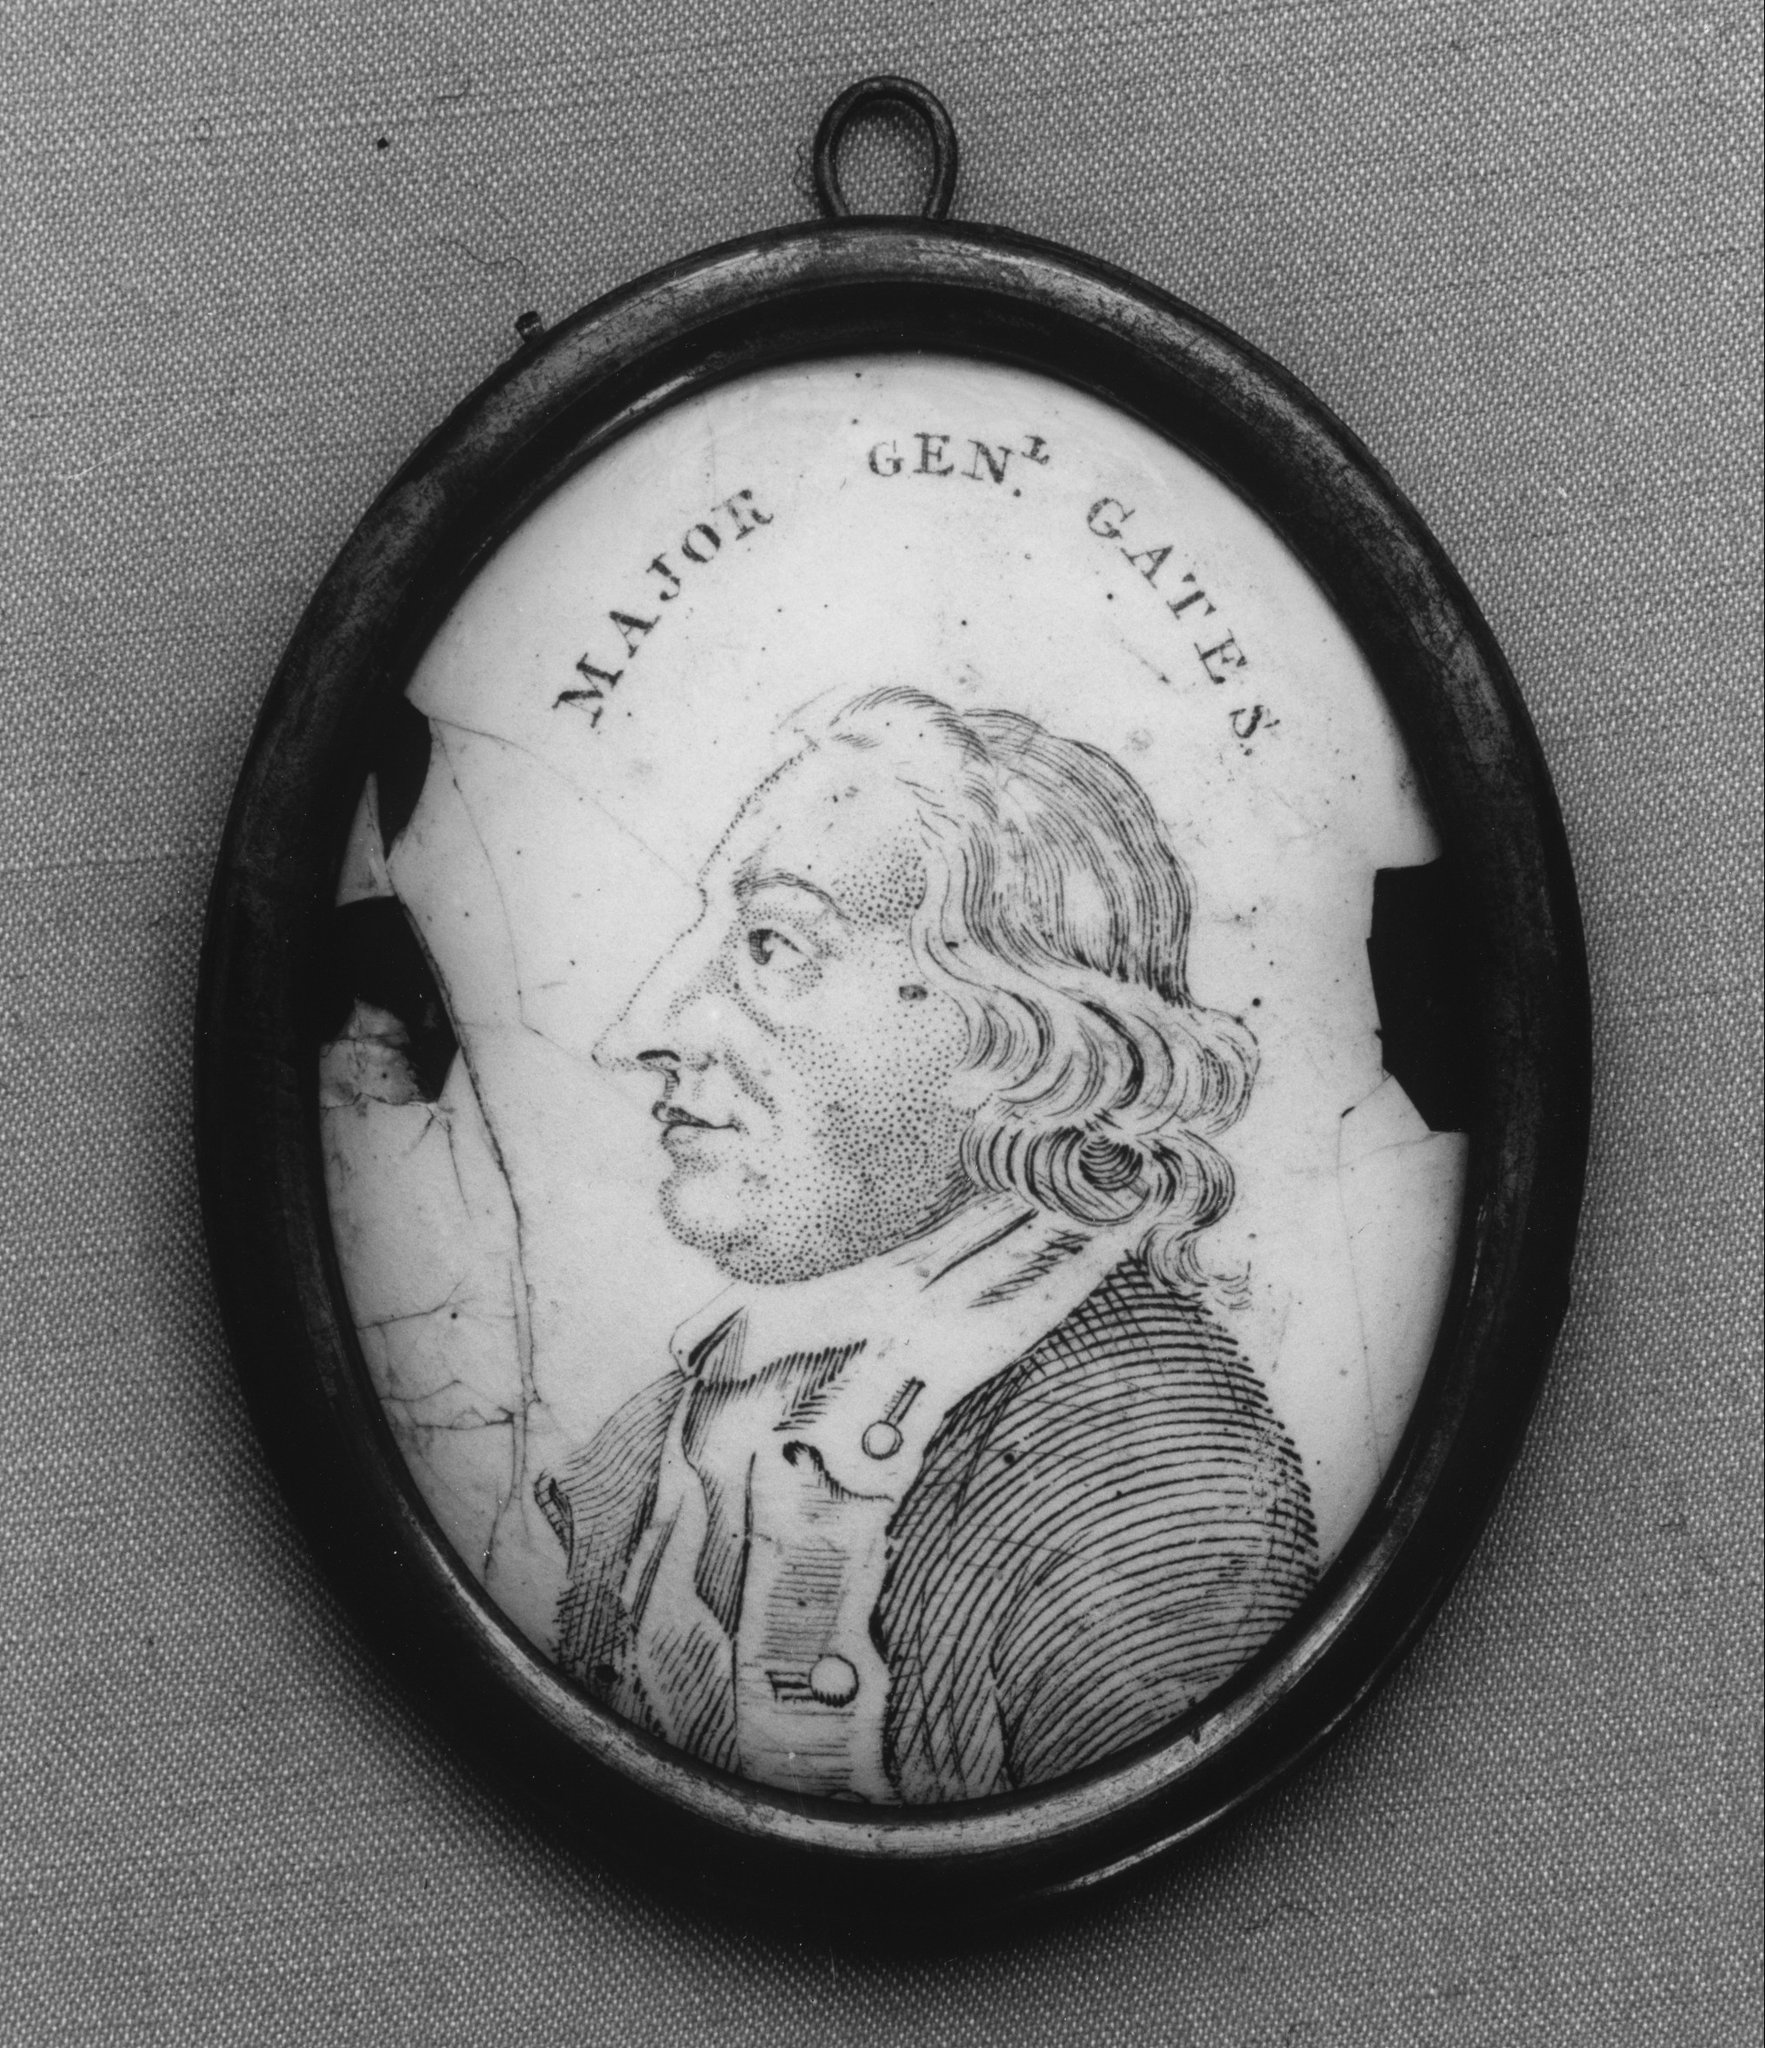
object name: painting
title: Plaque of George Washington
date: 1770-1800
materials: enamel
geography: england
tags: george washington,profiles